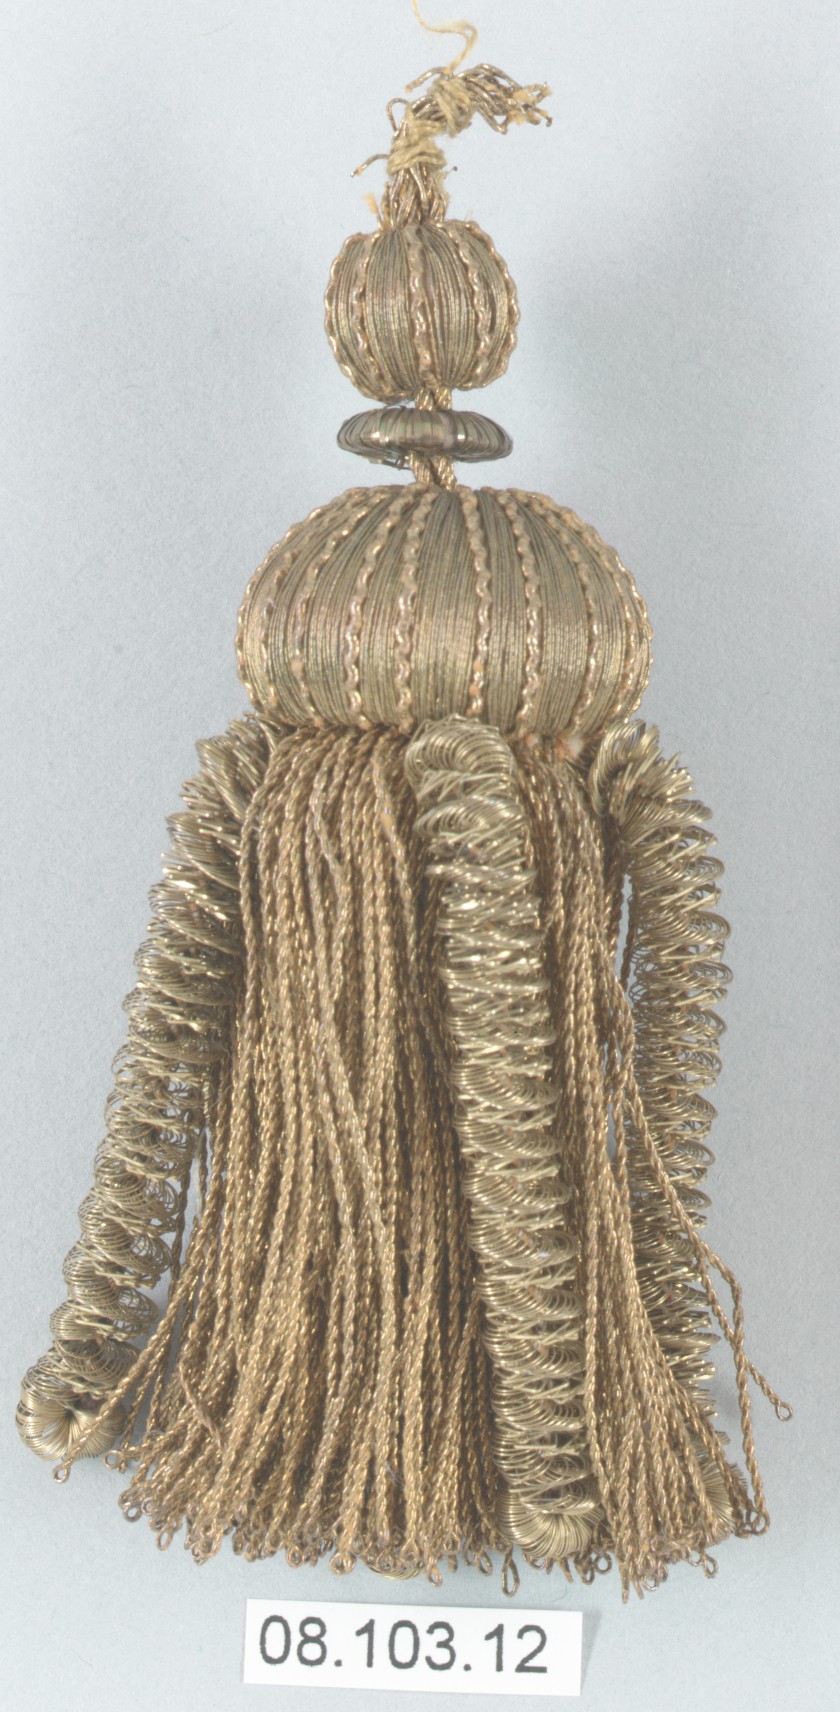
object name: tassel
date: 1701-1900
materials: metal thread